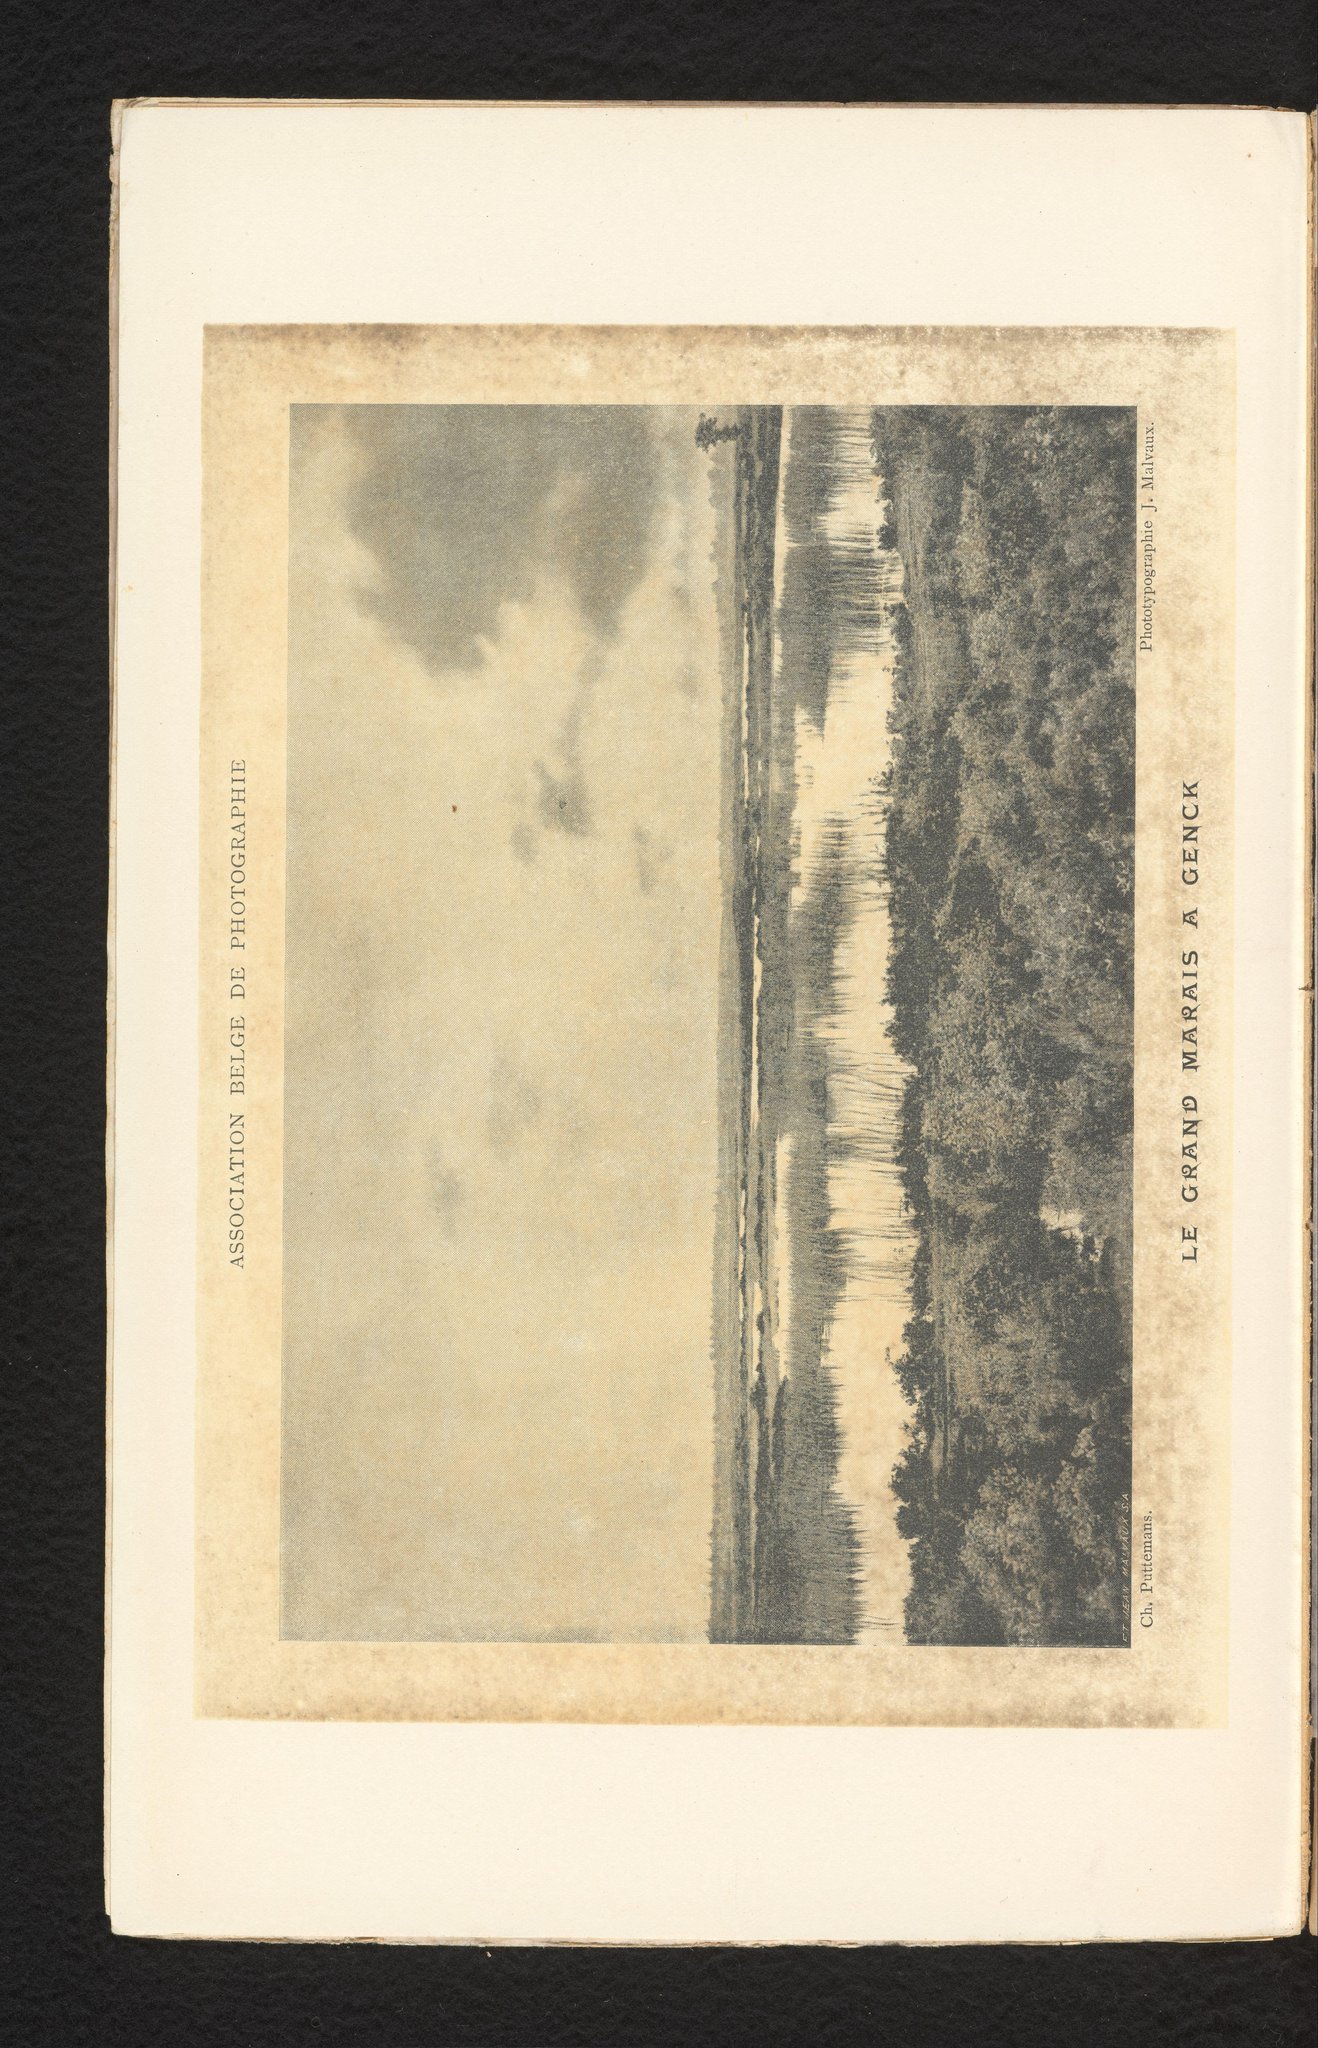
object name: page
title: Moeras bij Genk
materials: paper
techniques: autotype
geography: genk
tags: swamp, inland marsh, fens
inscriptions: inscription: ‘ASSOCIATION BELGE DE PHOTOGRAPHIE’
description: Prent op tweede ongenummerde pagina na pagina XVI.